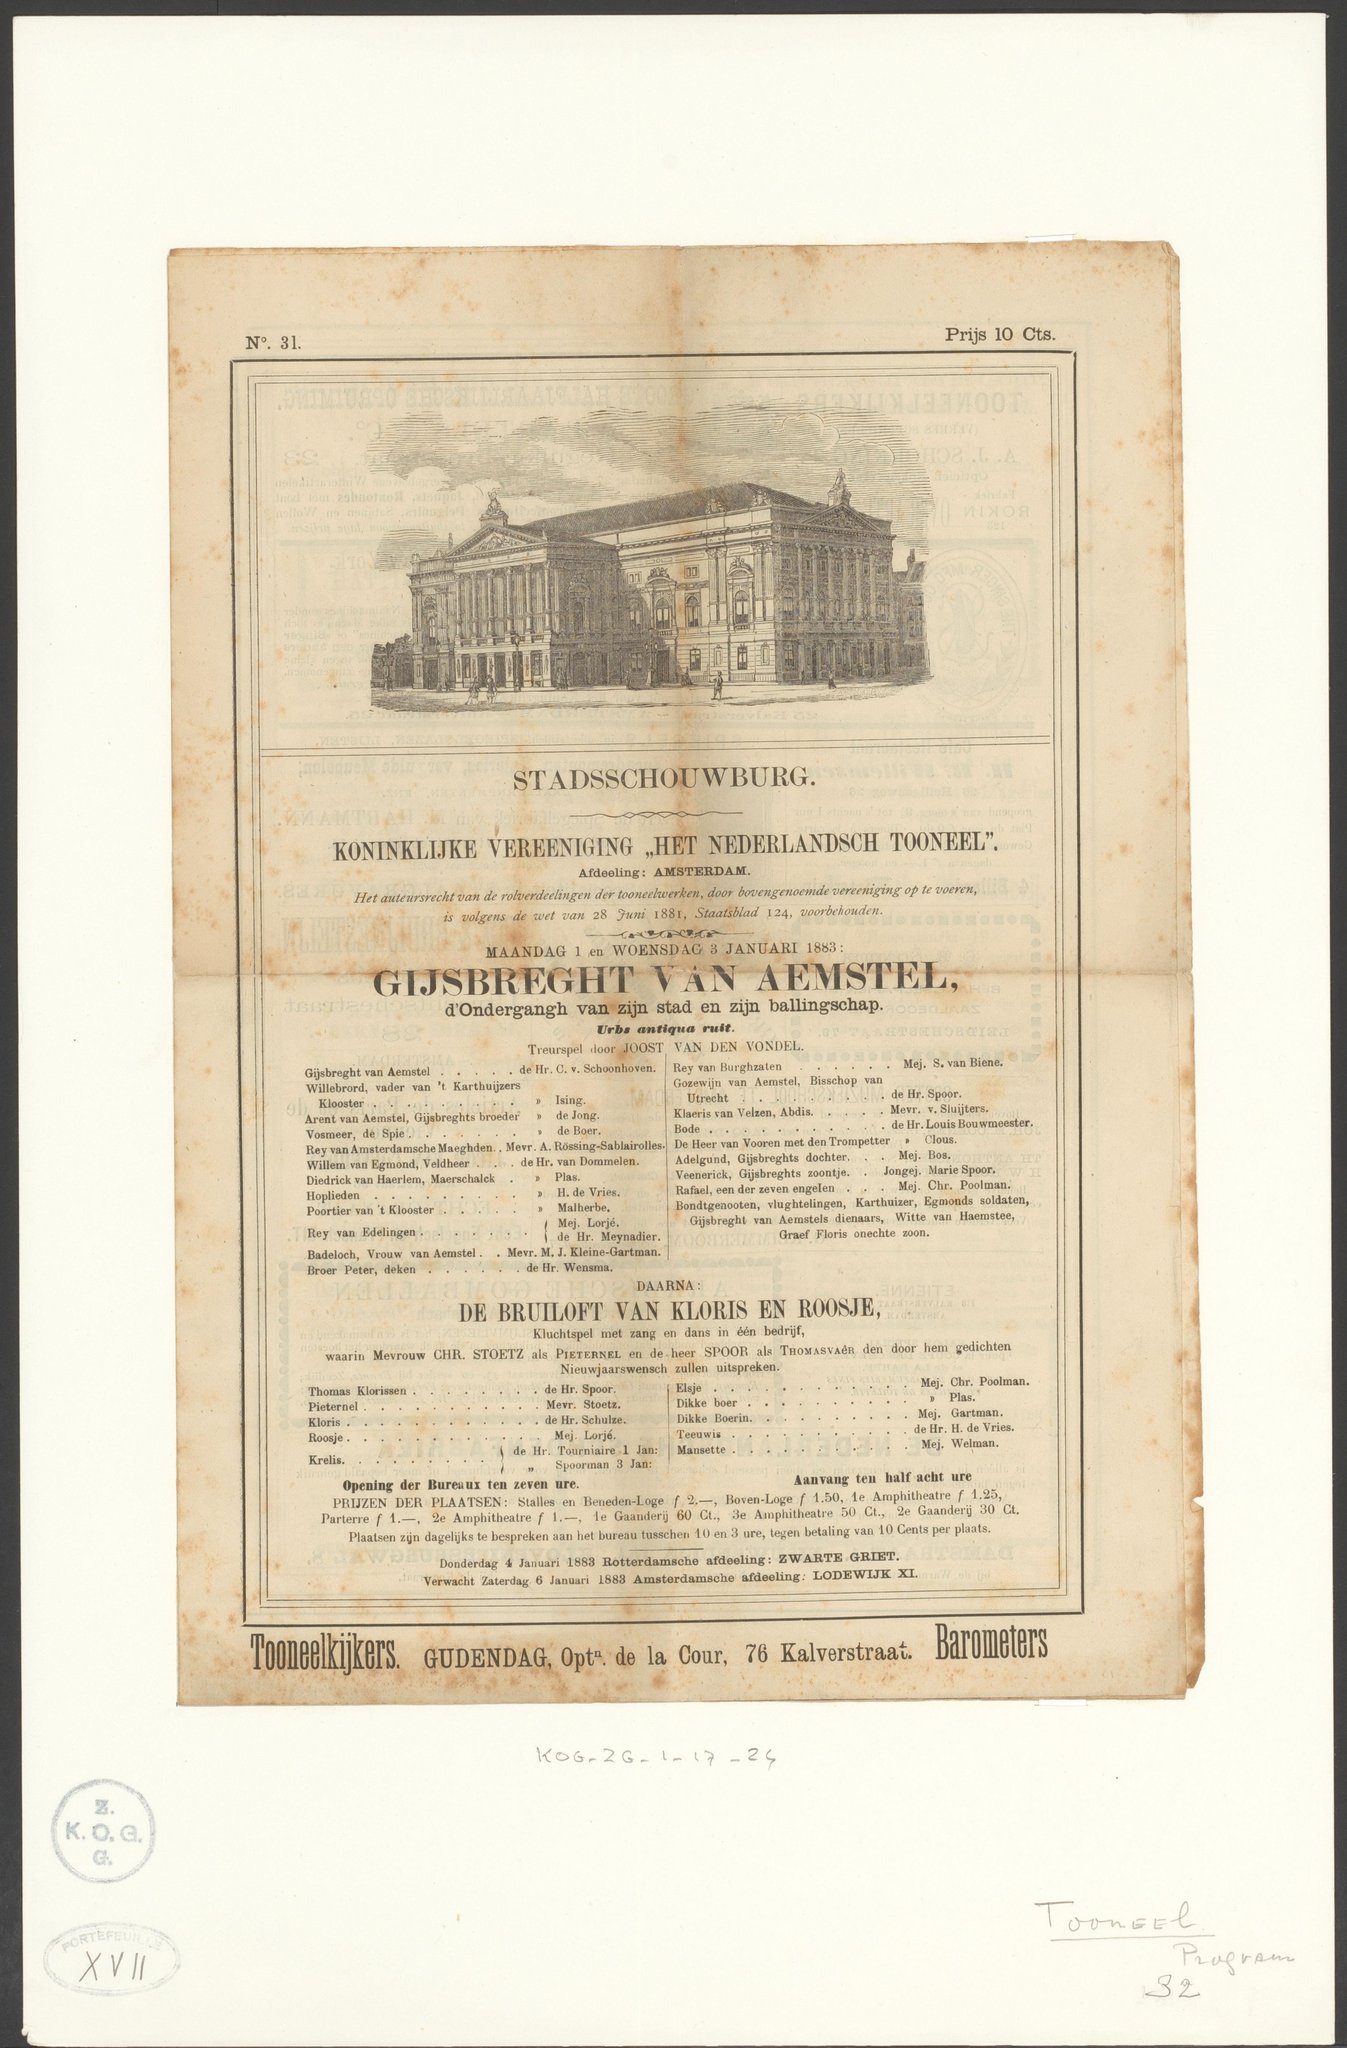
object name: text sheet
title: Amsterdamsche Gids met een aankondiging voor Gijsbreght van Aemstel en De bruiloft van Kloris en Roosje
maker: Anonymous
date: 1883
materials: paper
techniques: letterpress printing, engraving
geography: amsterdam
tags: theatre, theatrical performance, advertisement, notice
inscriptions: collector's mark: Lugt 1641, stamp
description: Twee in elkaar gevouwen bladen vormen samen zes pagina's. Op de eerste pagina een aankondiging van de aankomende voorstellingen Gijsbeght van Aemstel en De bruiloft van Kloris en Roosje in de Stadsschouwburg op 1 en 3 januari 1883. Op de overige pagina's advertenties. Linksboven genummerd: No. 31. Onderwerpsrubrieken binnen de Atlas Zeden en Gewoonten: Tooneel, Toneelprogramma’s.